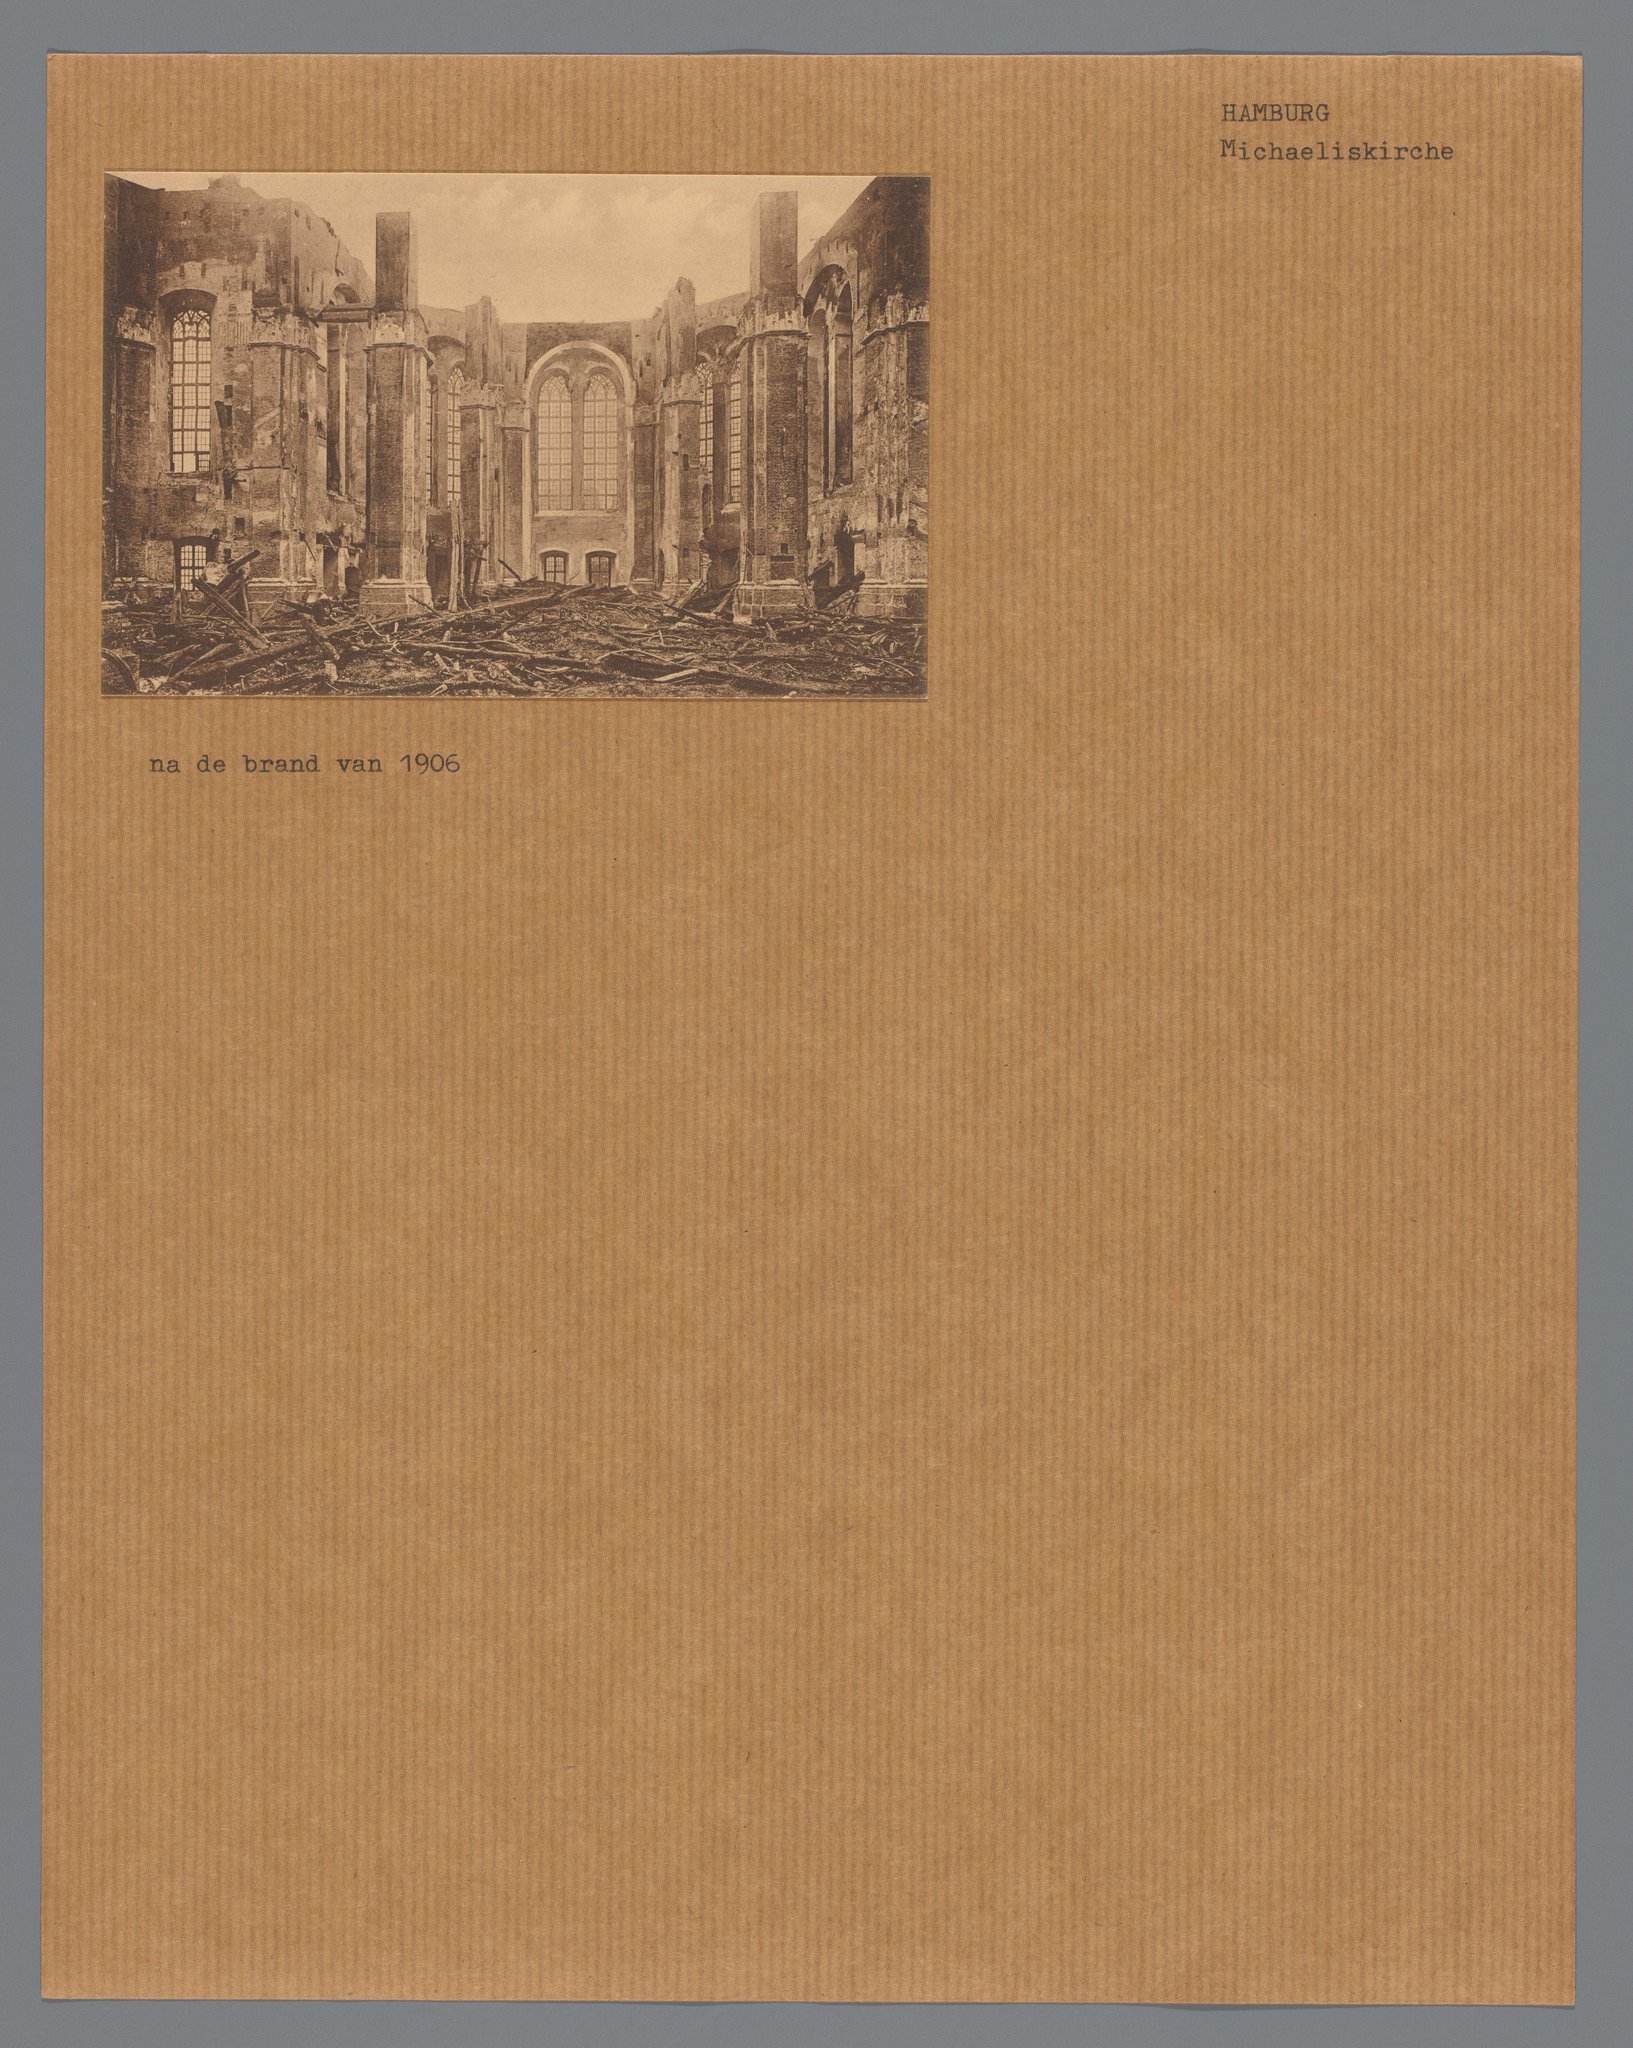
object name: photograph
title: Hamburg, Michaeliskirche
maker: Anonymous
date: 1906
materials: photographic support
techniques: rotogravure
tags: hamburg